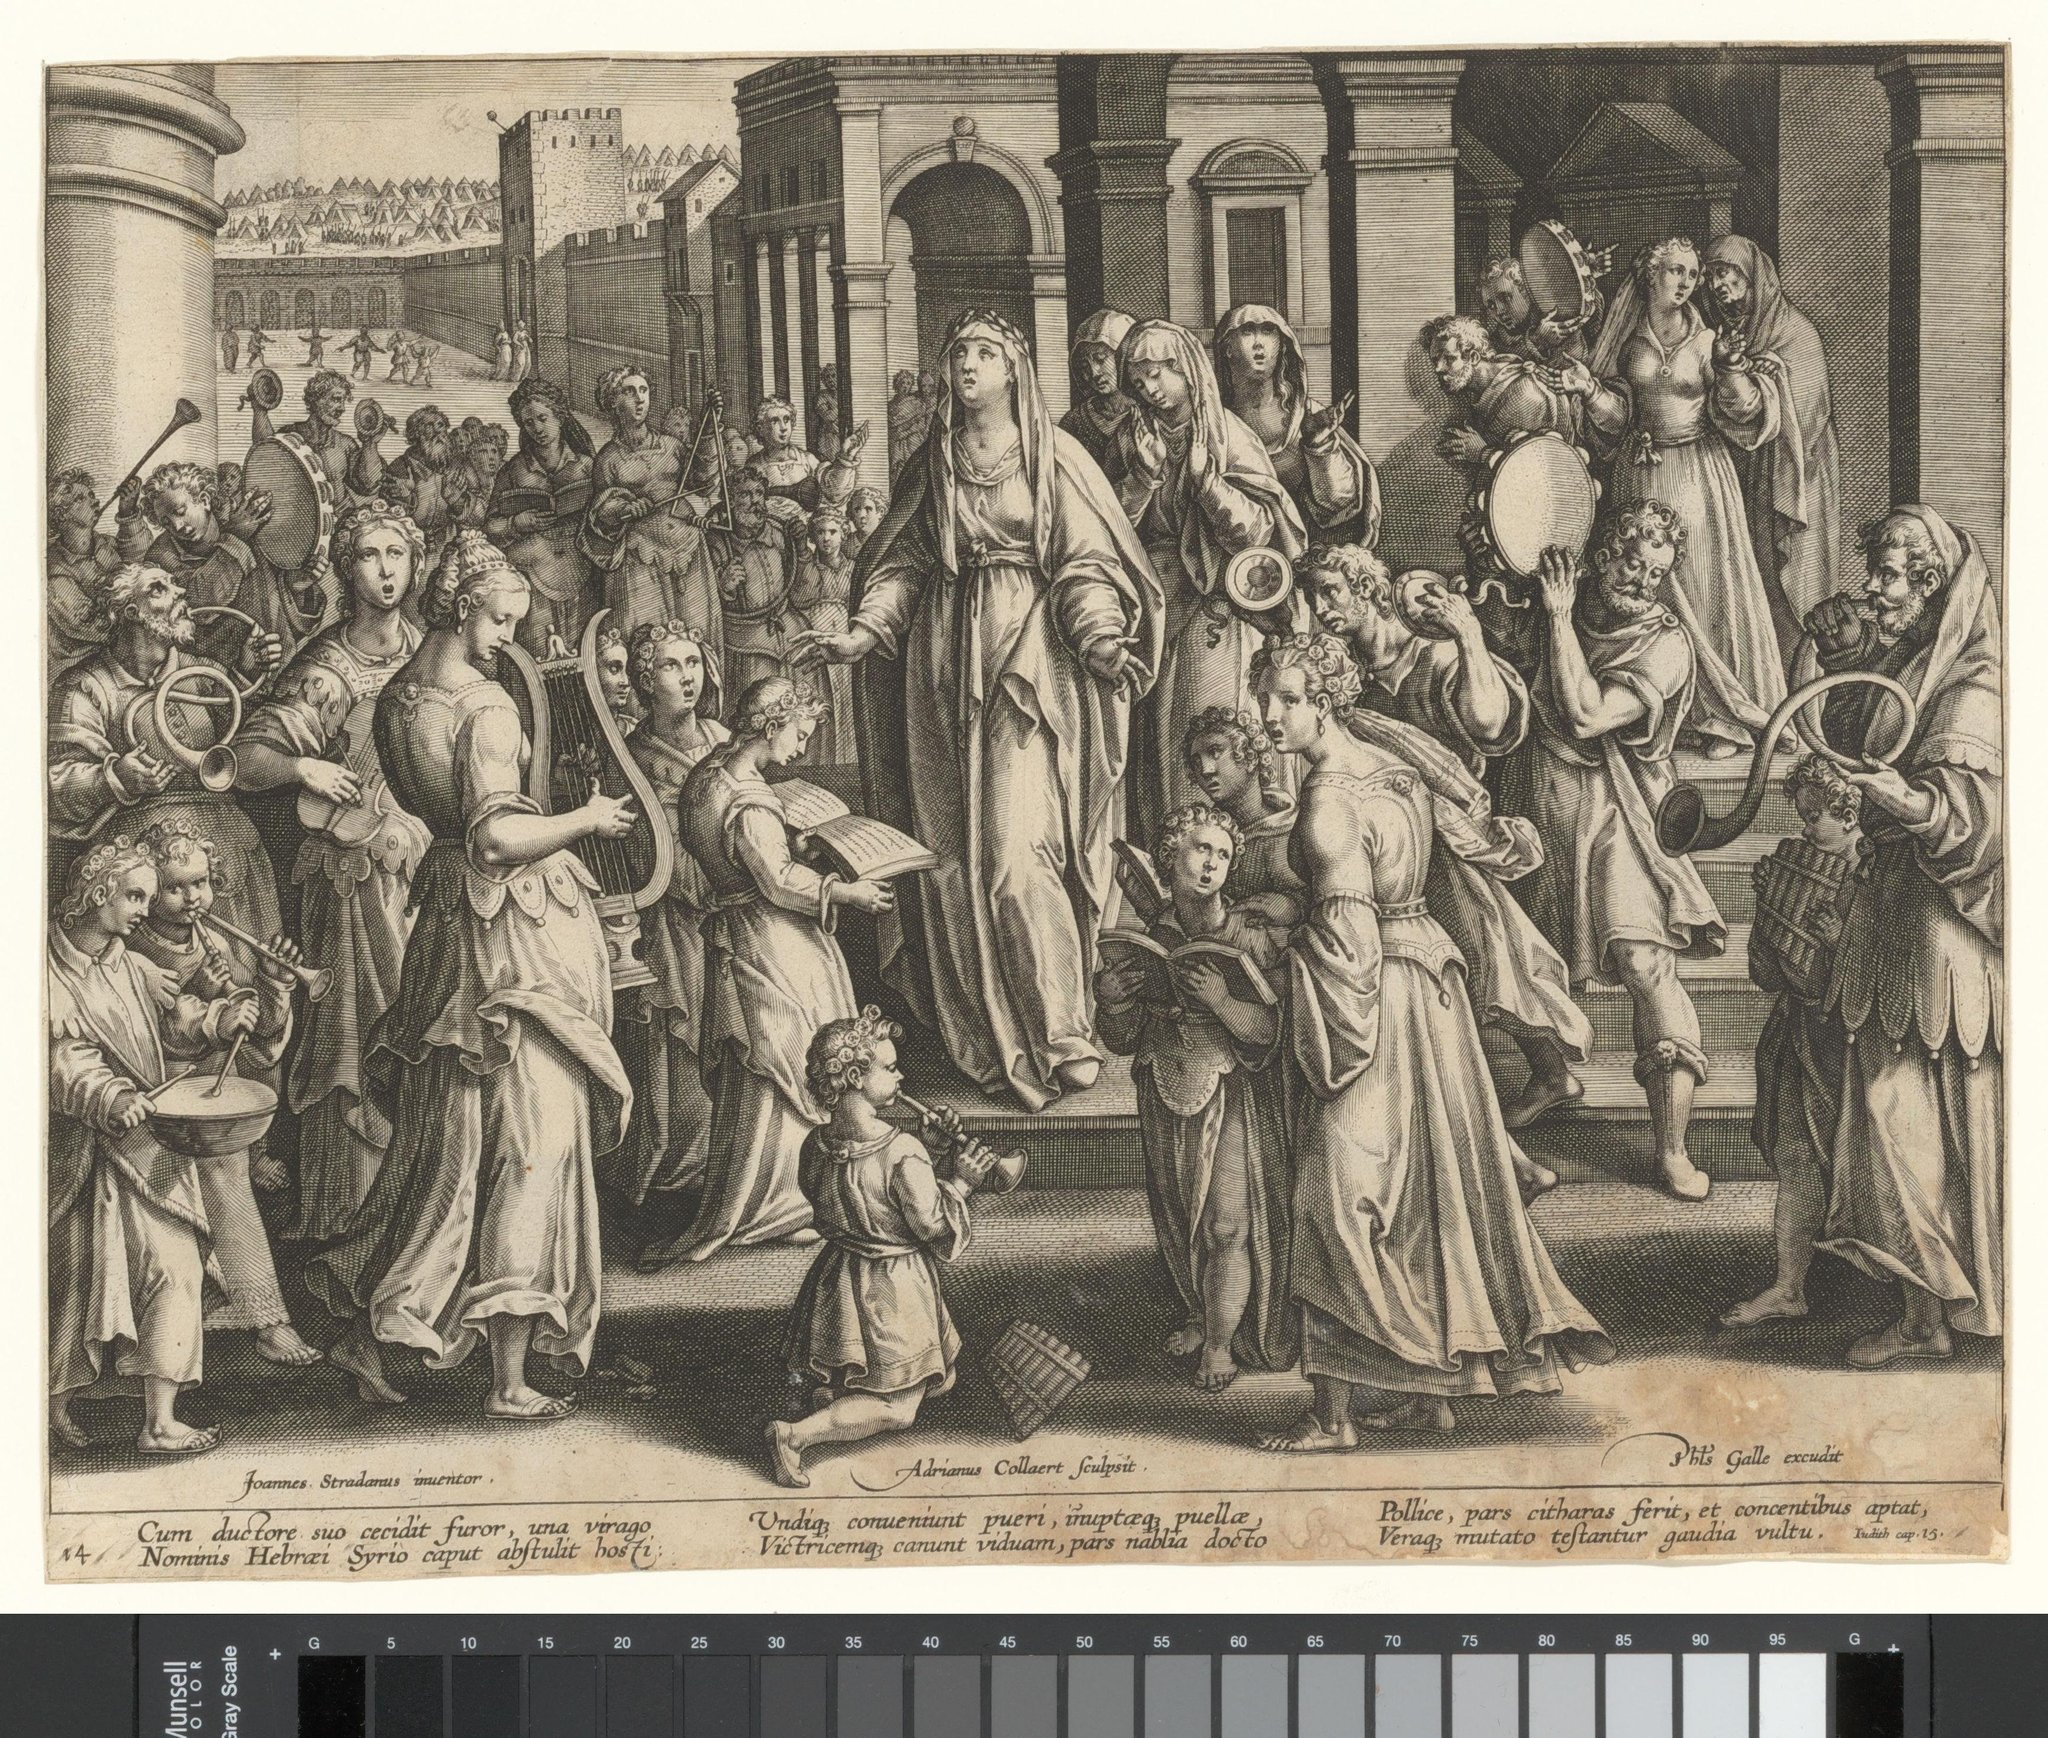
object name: print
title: Loflied op de muziek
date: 1587-1592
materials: paper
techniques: engraving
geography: antwerp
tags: musical instruments; group of musical instruments, victory of the israelites ~ judith and holofernes, printed edition of musical score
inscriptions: stamp, collector's mark: Lugt 1641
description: Judit staat te midden van een groep Israëlieten die muziekinstrumenten (lier, hoorns, bazuin, tamboerijn, panfluit, trommels en triangel) bespelen en zingen uit een muziekboek. Judit heeft een lauwerkrans op haar hoofd. De prent heeft een Latijns onderschrift met verzen. Rechtsonder een verwijzing naar Judit 15. De prent heeft een Latijns onderschrift met verzen. Linksonder genummerd: 14. Onderwerpsrubrieken binnen de Atlas Zeden en Gewoonten: Muziek en muziekinstrumenten: Muziekinstrumenten op bijbelprenten.